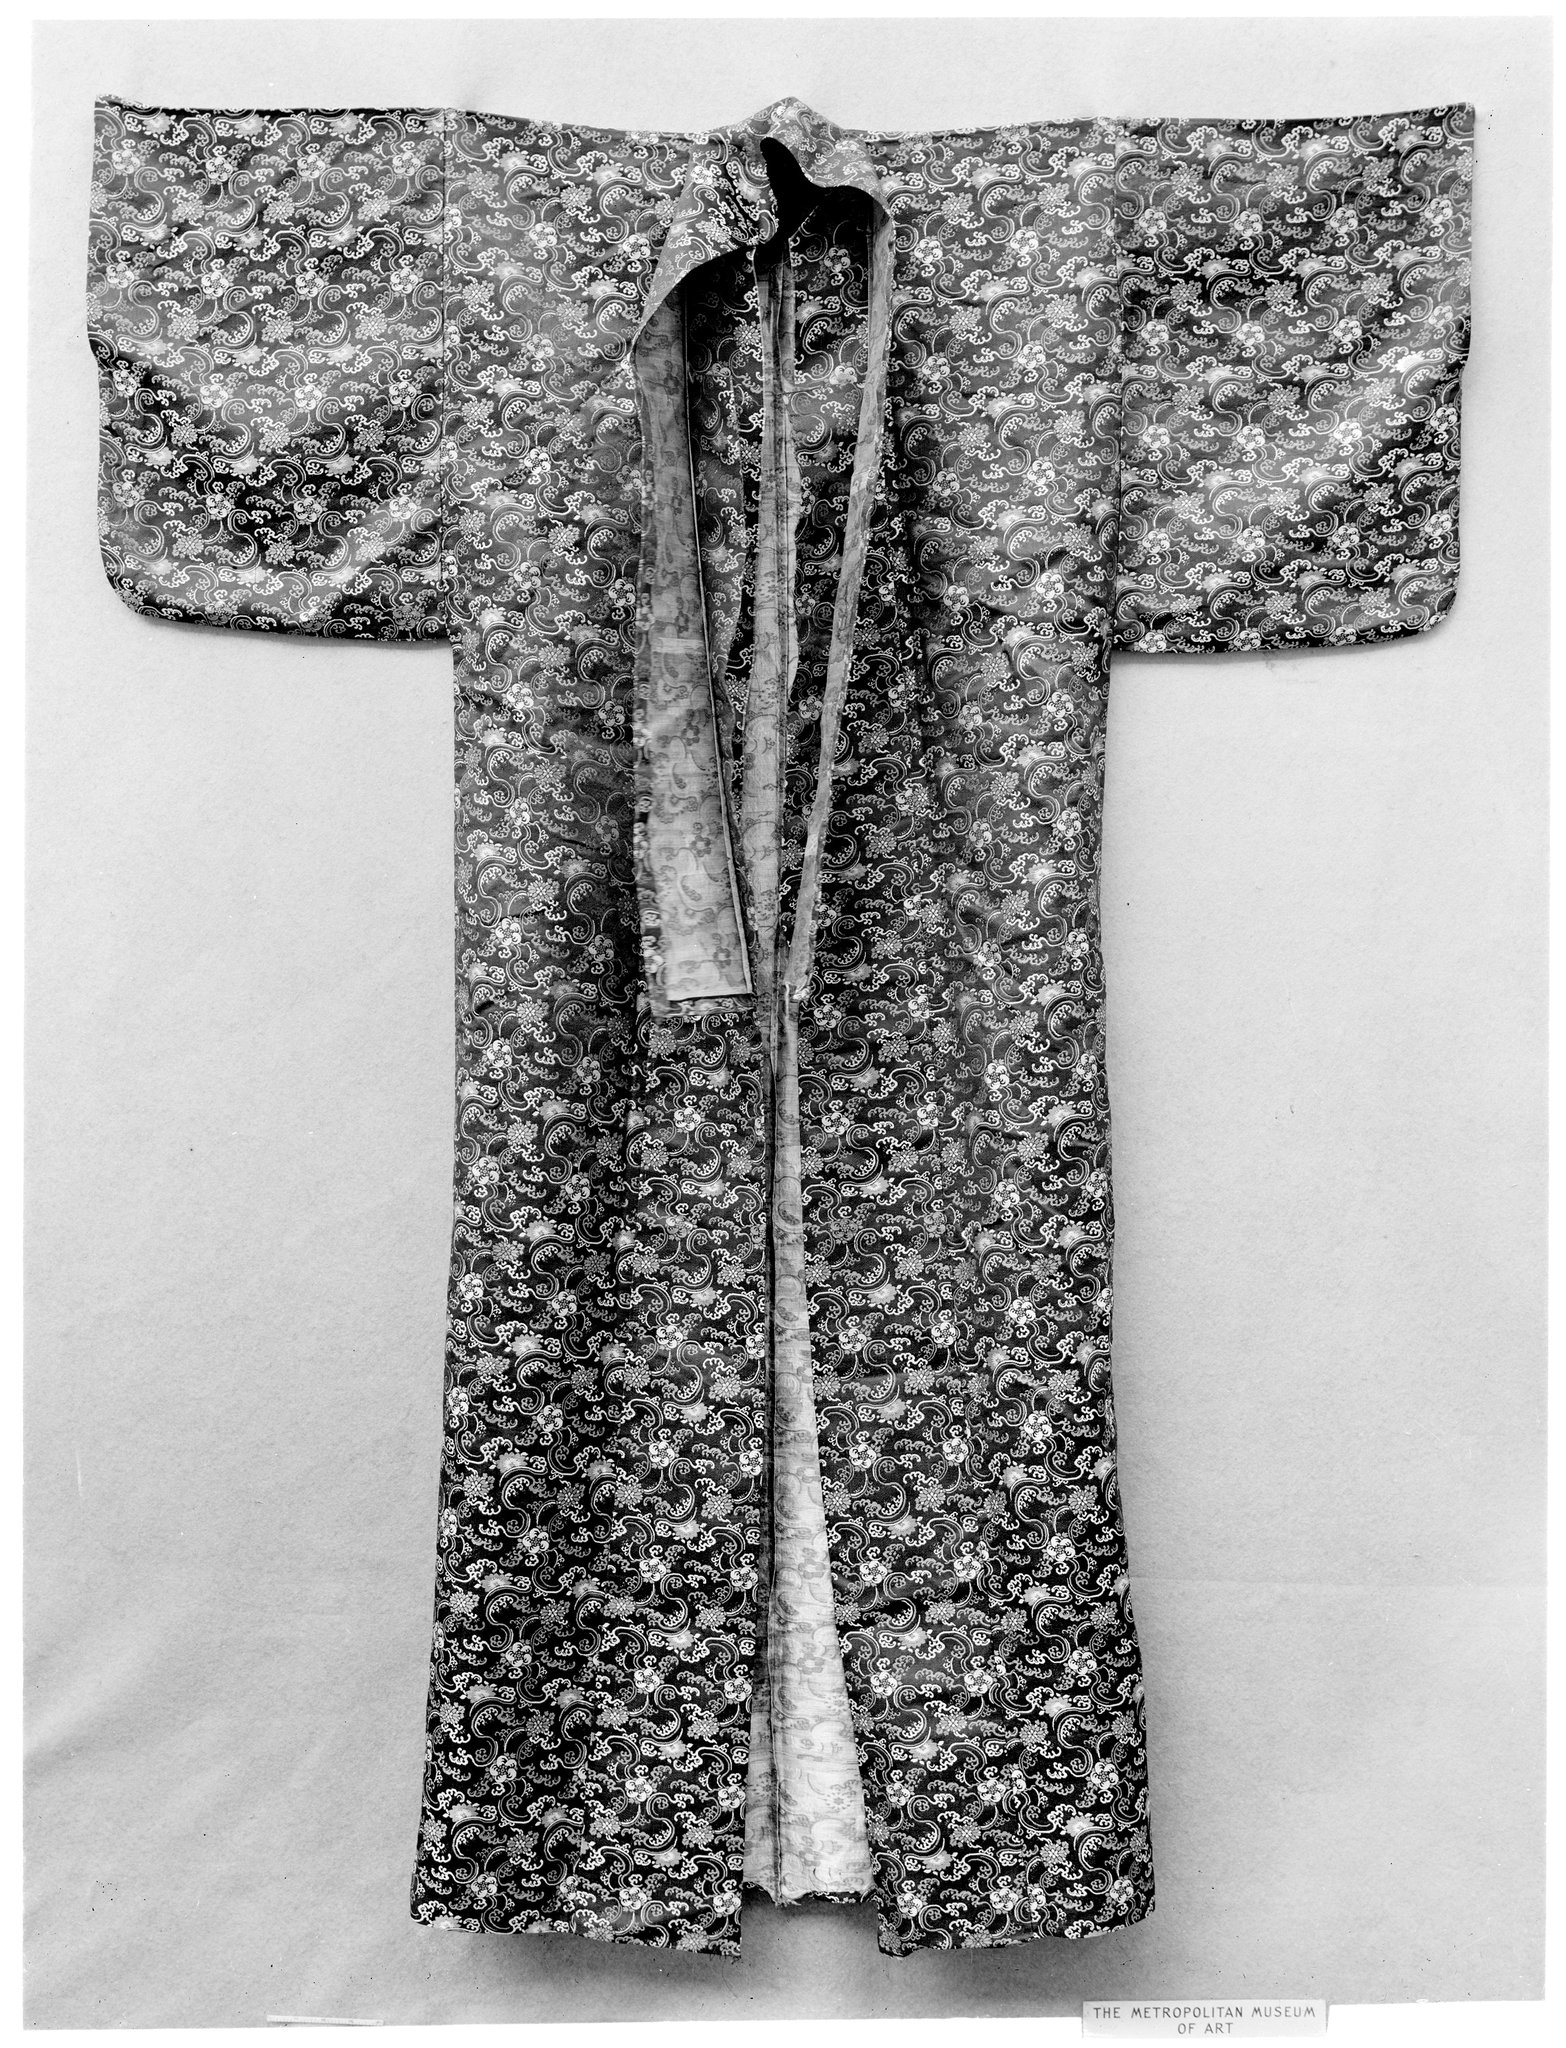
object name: kosode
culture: japanese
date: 1801-1900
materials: metal thread, silk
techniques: lampas